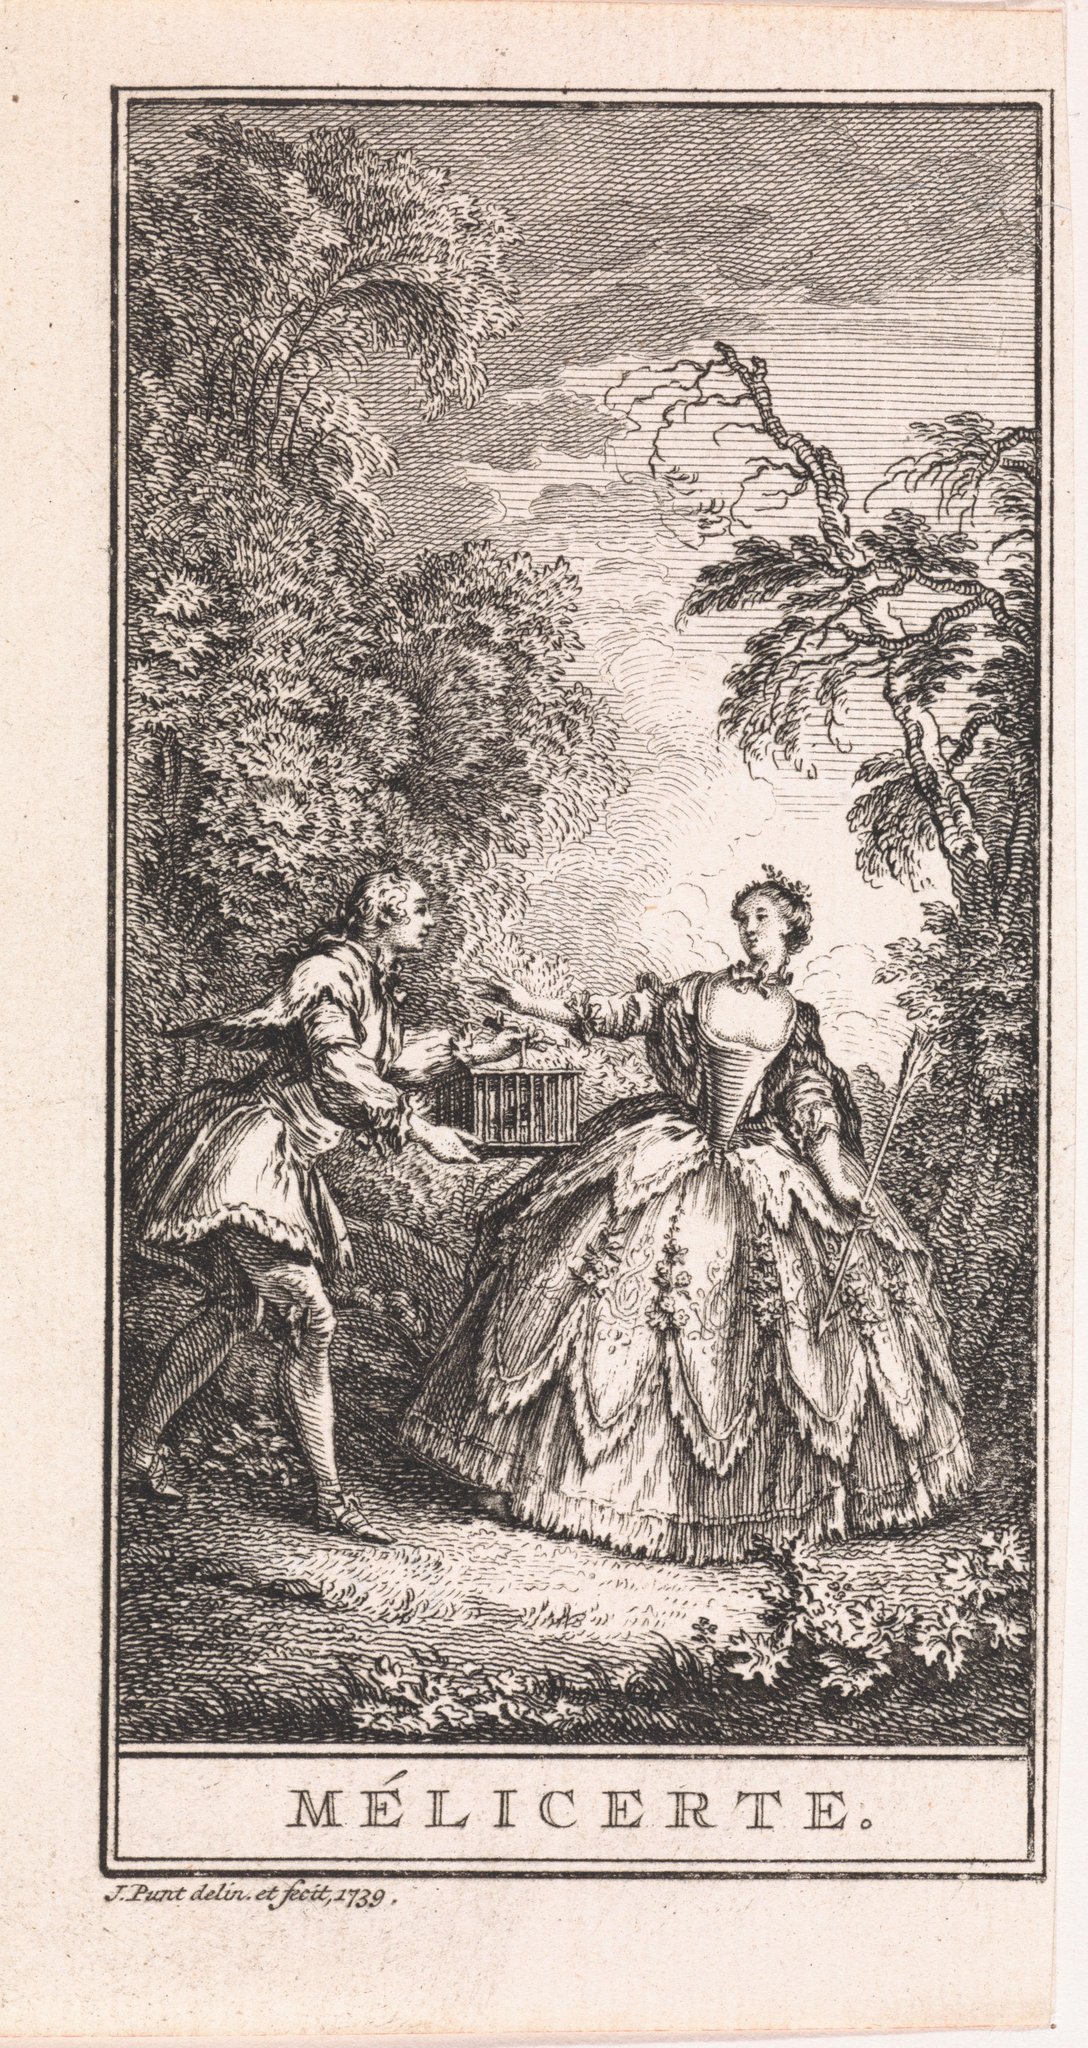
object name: book illustration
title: Man geeft vrouw een vogelkooi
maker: jan punt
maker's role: draughtsman, print maker, publisher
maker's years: 1711-1779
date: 1739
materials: paper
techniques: engraving, etching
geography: amsterdam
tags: (moliere) specific works of literature (with author, title), bird in a cage, couple of lovers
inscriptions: collector's mark: Lugt 2228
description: Prent gebruikt als illustratie in: Oeuvres de Molière, Nouvelle Edition, deel II, p. 450. Amsterdam en Leipzig: Johann Caspar Arkstee & Henricus Merkus, 1750.